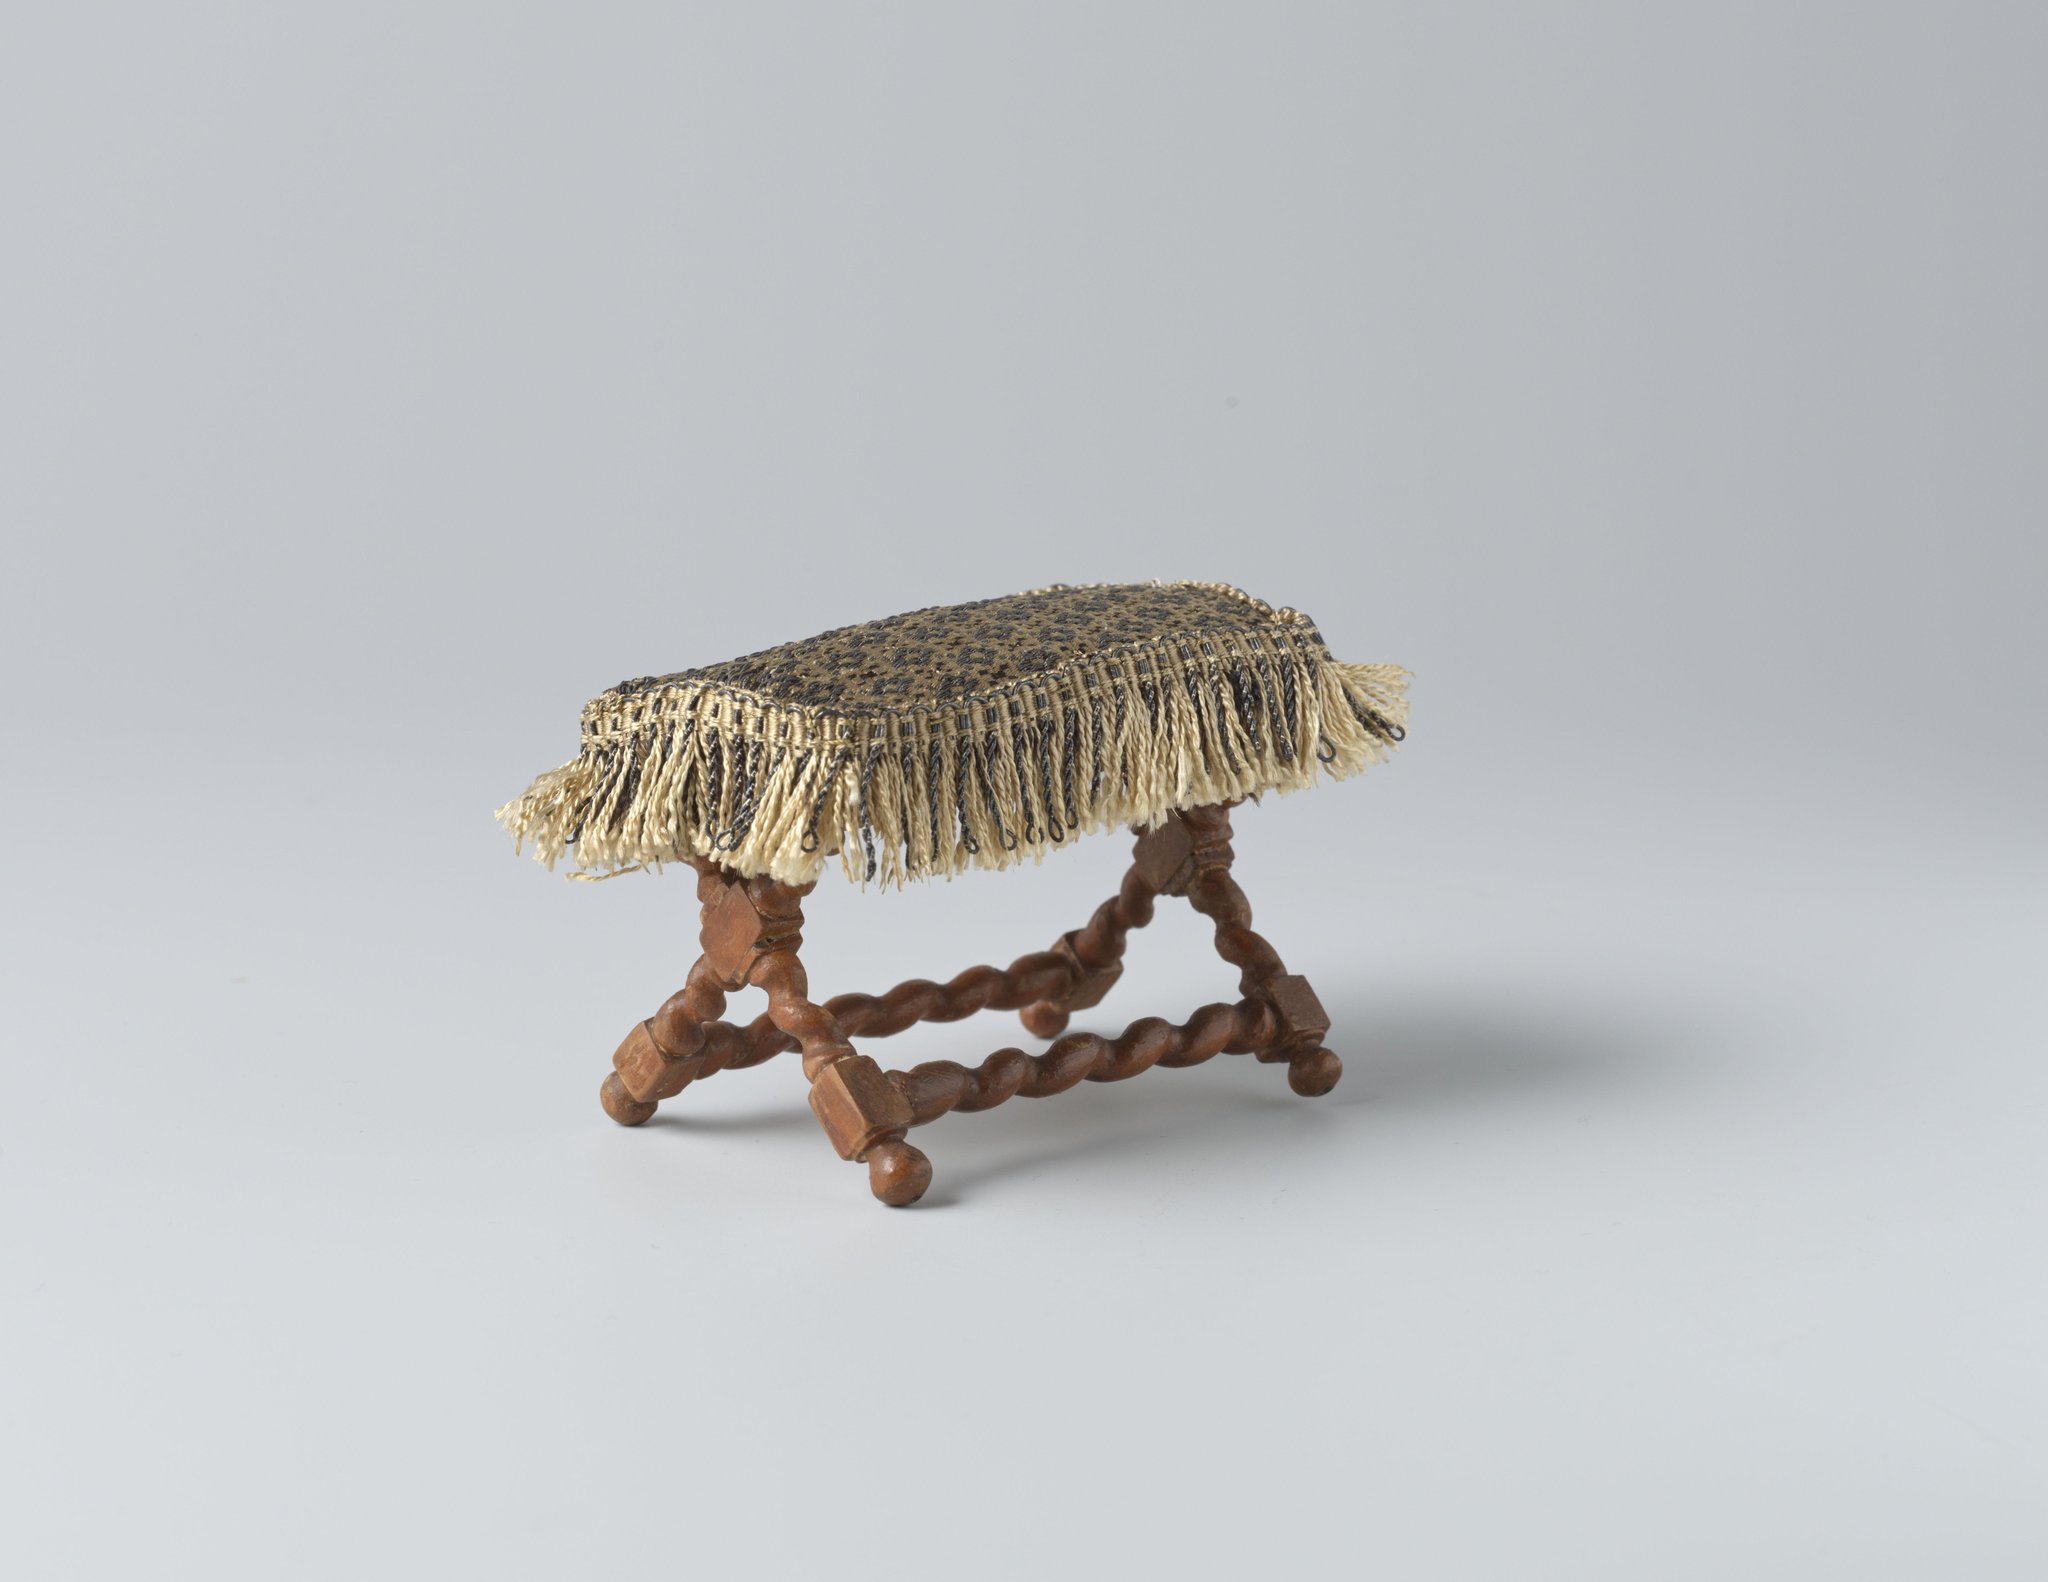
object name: tabouret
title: Taboeret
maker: Anonymous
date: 1676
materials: linen, wood, silk, thread, wool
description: Taboeret met rechthoekige zitting, op getorste poten van olijfhout, de poten zijn twee aan twee gekruist en worden verbonden aan de onderzijde door twee getorste dwarspoten, en boven door twee gladde dwarsregels. Tussen de bovenregels is de zitting gespannen, bestaande uit een linnen onderlaag, waarop wolpluis, afgedekt door een complex weefsel van zijde en metaaldraad met geometrisch patroon in de kleuren geel en zwart. De stof is rondom afgezet met passement met franje van dezelfde gele en zwarte zijde en verguld zilverdraad.